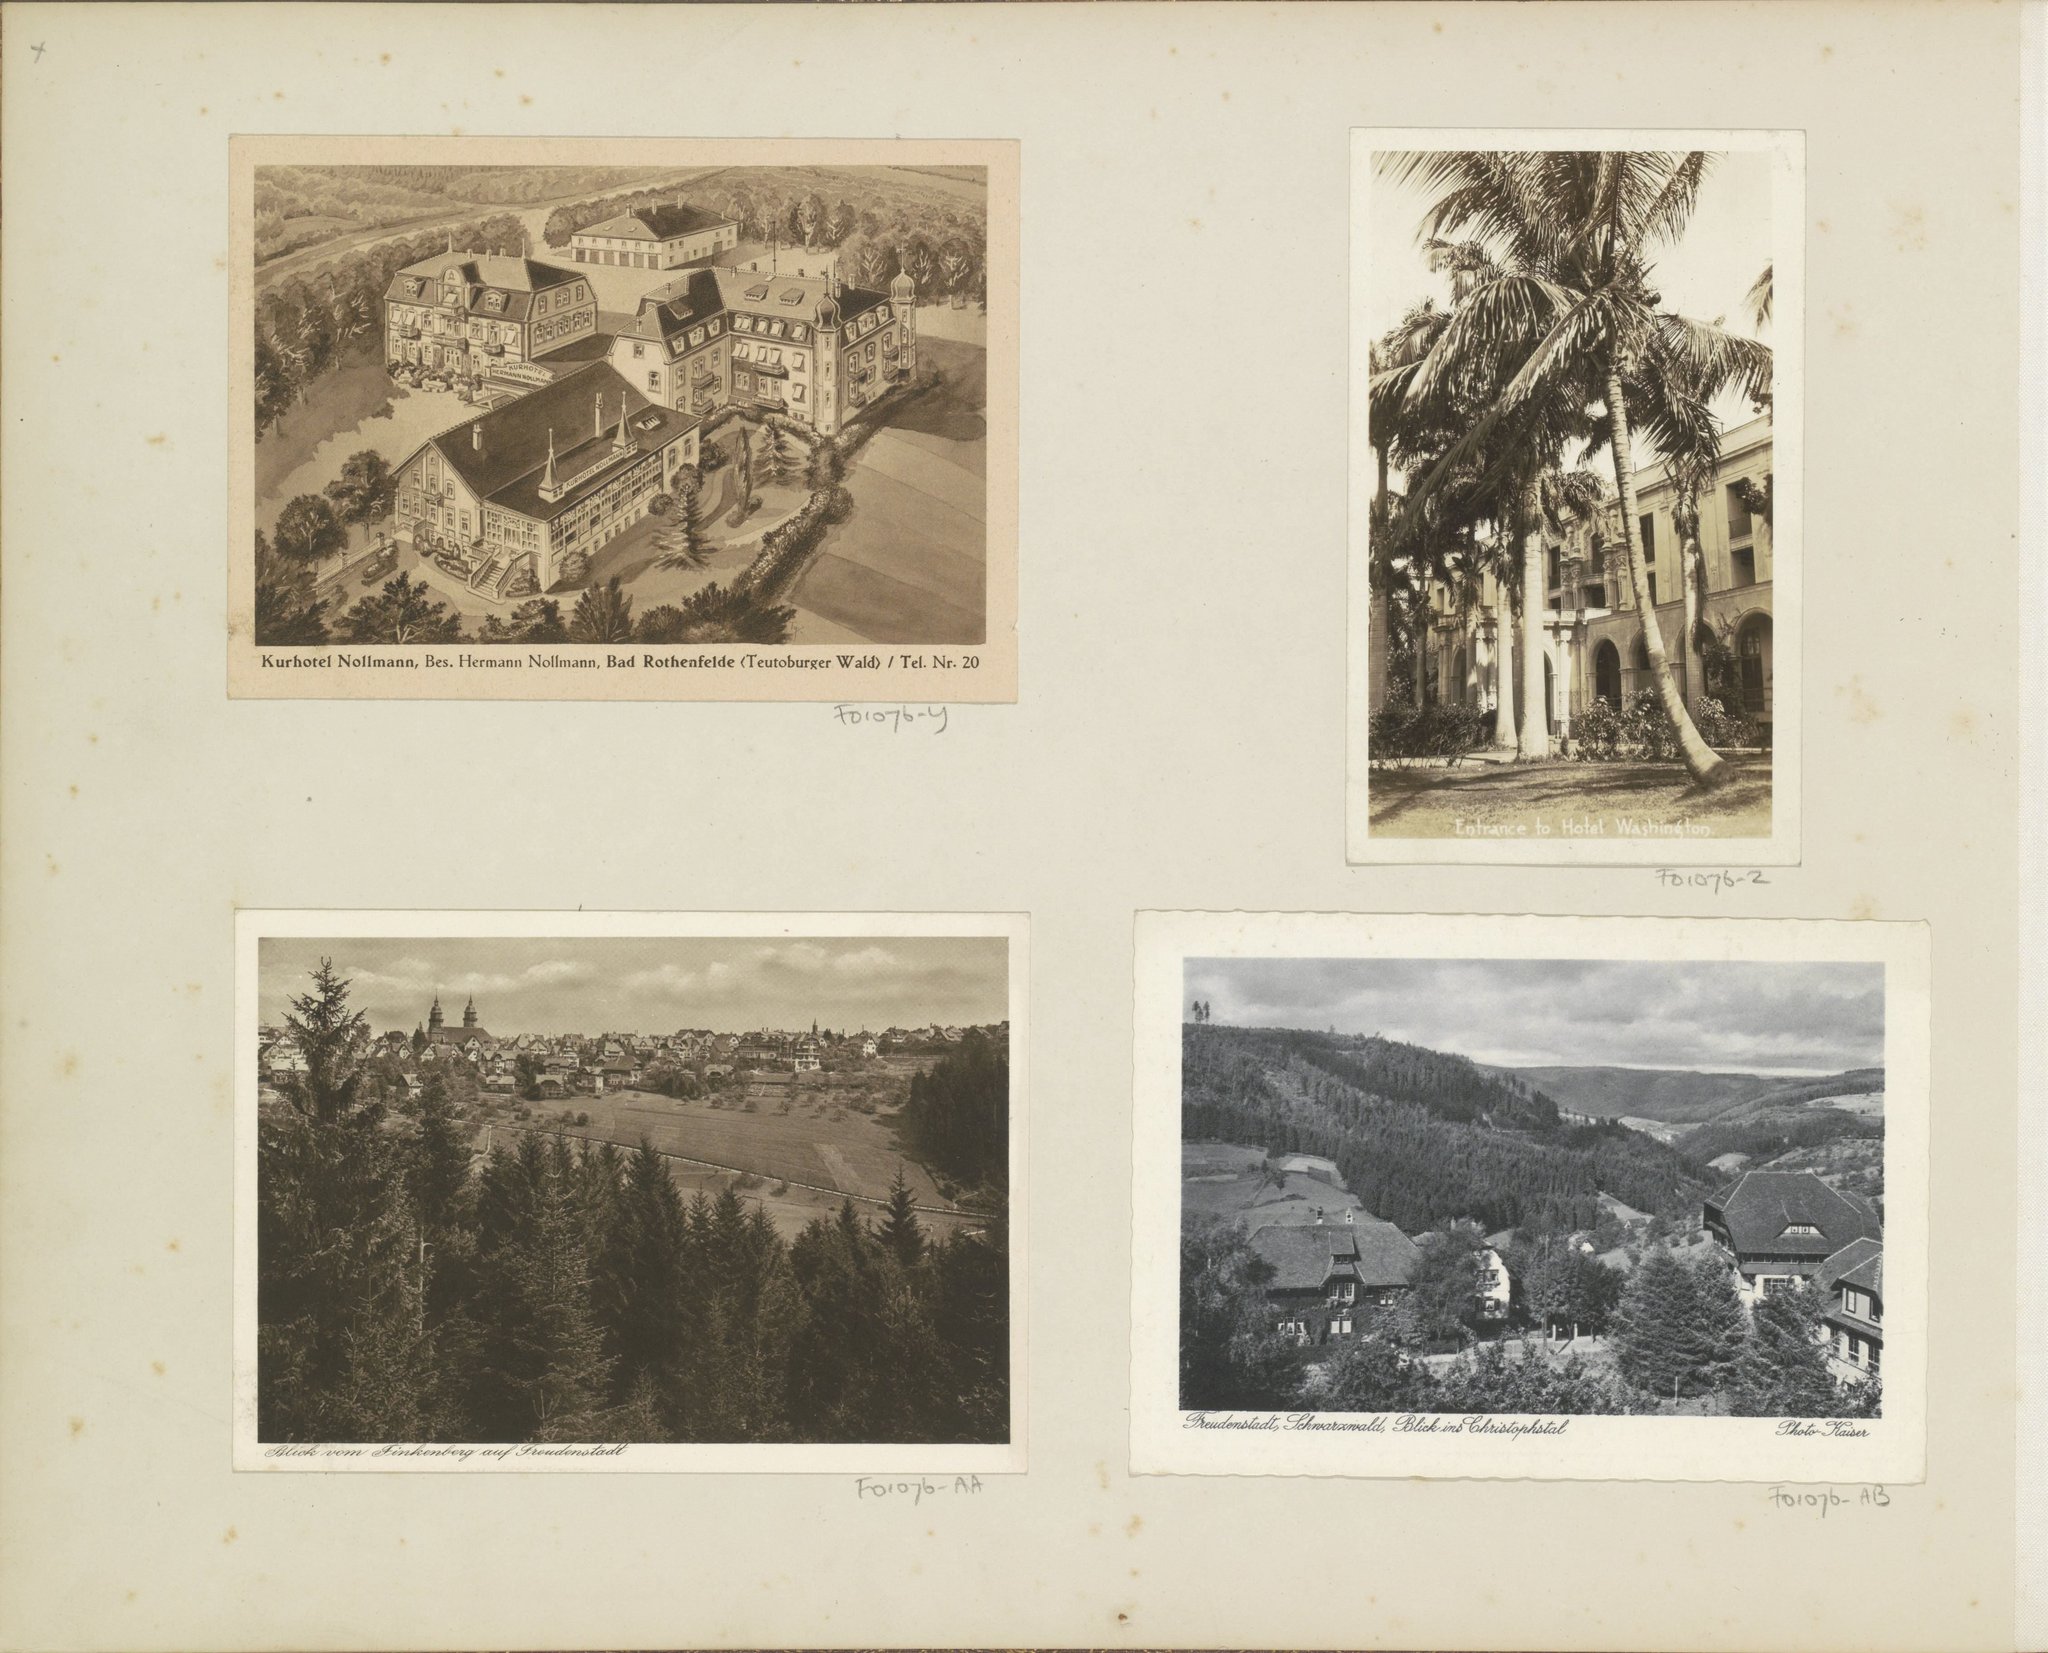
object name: album leaf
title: Gezicht op Freudenstadt vanaf de Finkenberg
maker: Anonymous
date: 1900-1940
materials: cardboard, paper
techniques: rotogravure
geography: freudenstadt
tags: dale, valley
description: Onderdeel van Album met foto's van spoorwegen in Nederlands-Indië en prentbriefkaarten.